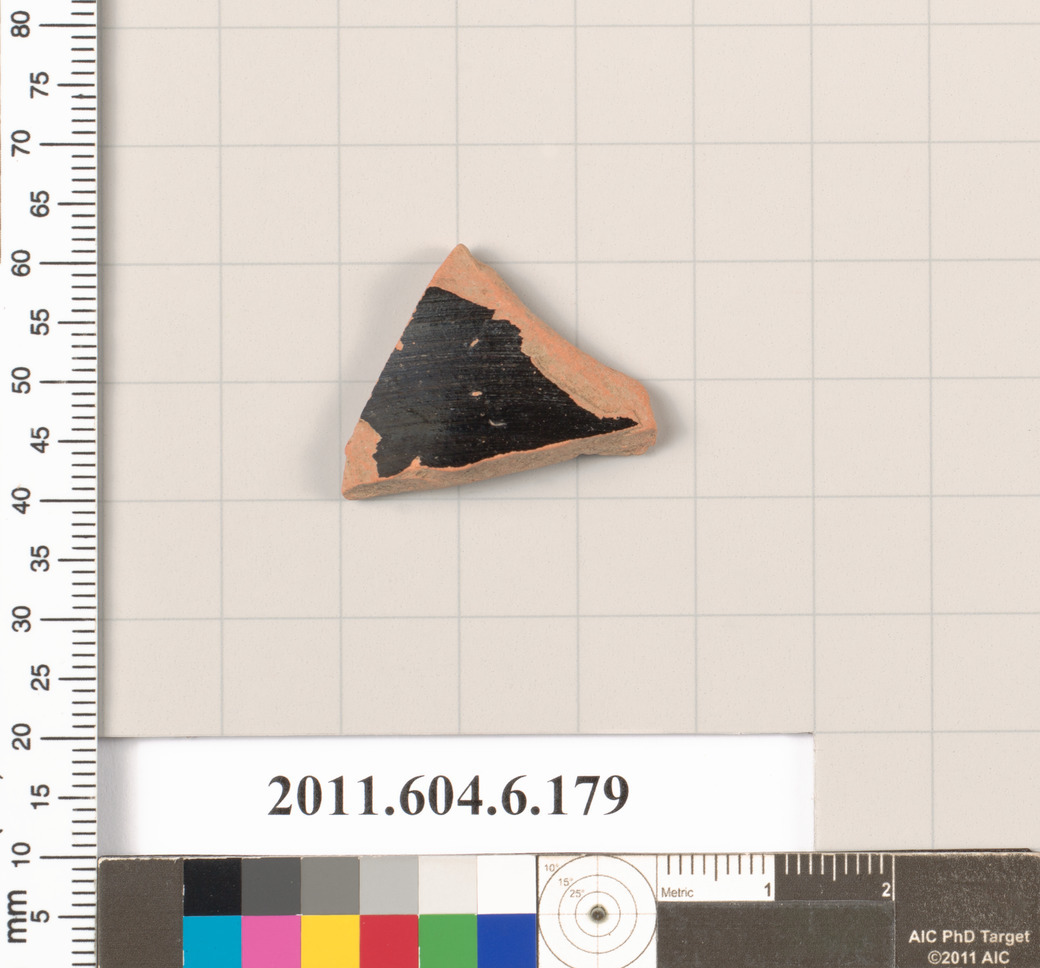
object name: oinochoe fragment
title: Terracotta fragment of an oinochoe (jug)?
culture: greek, attic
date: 500-401 BCE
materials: terracotta